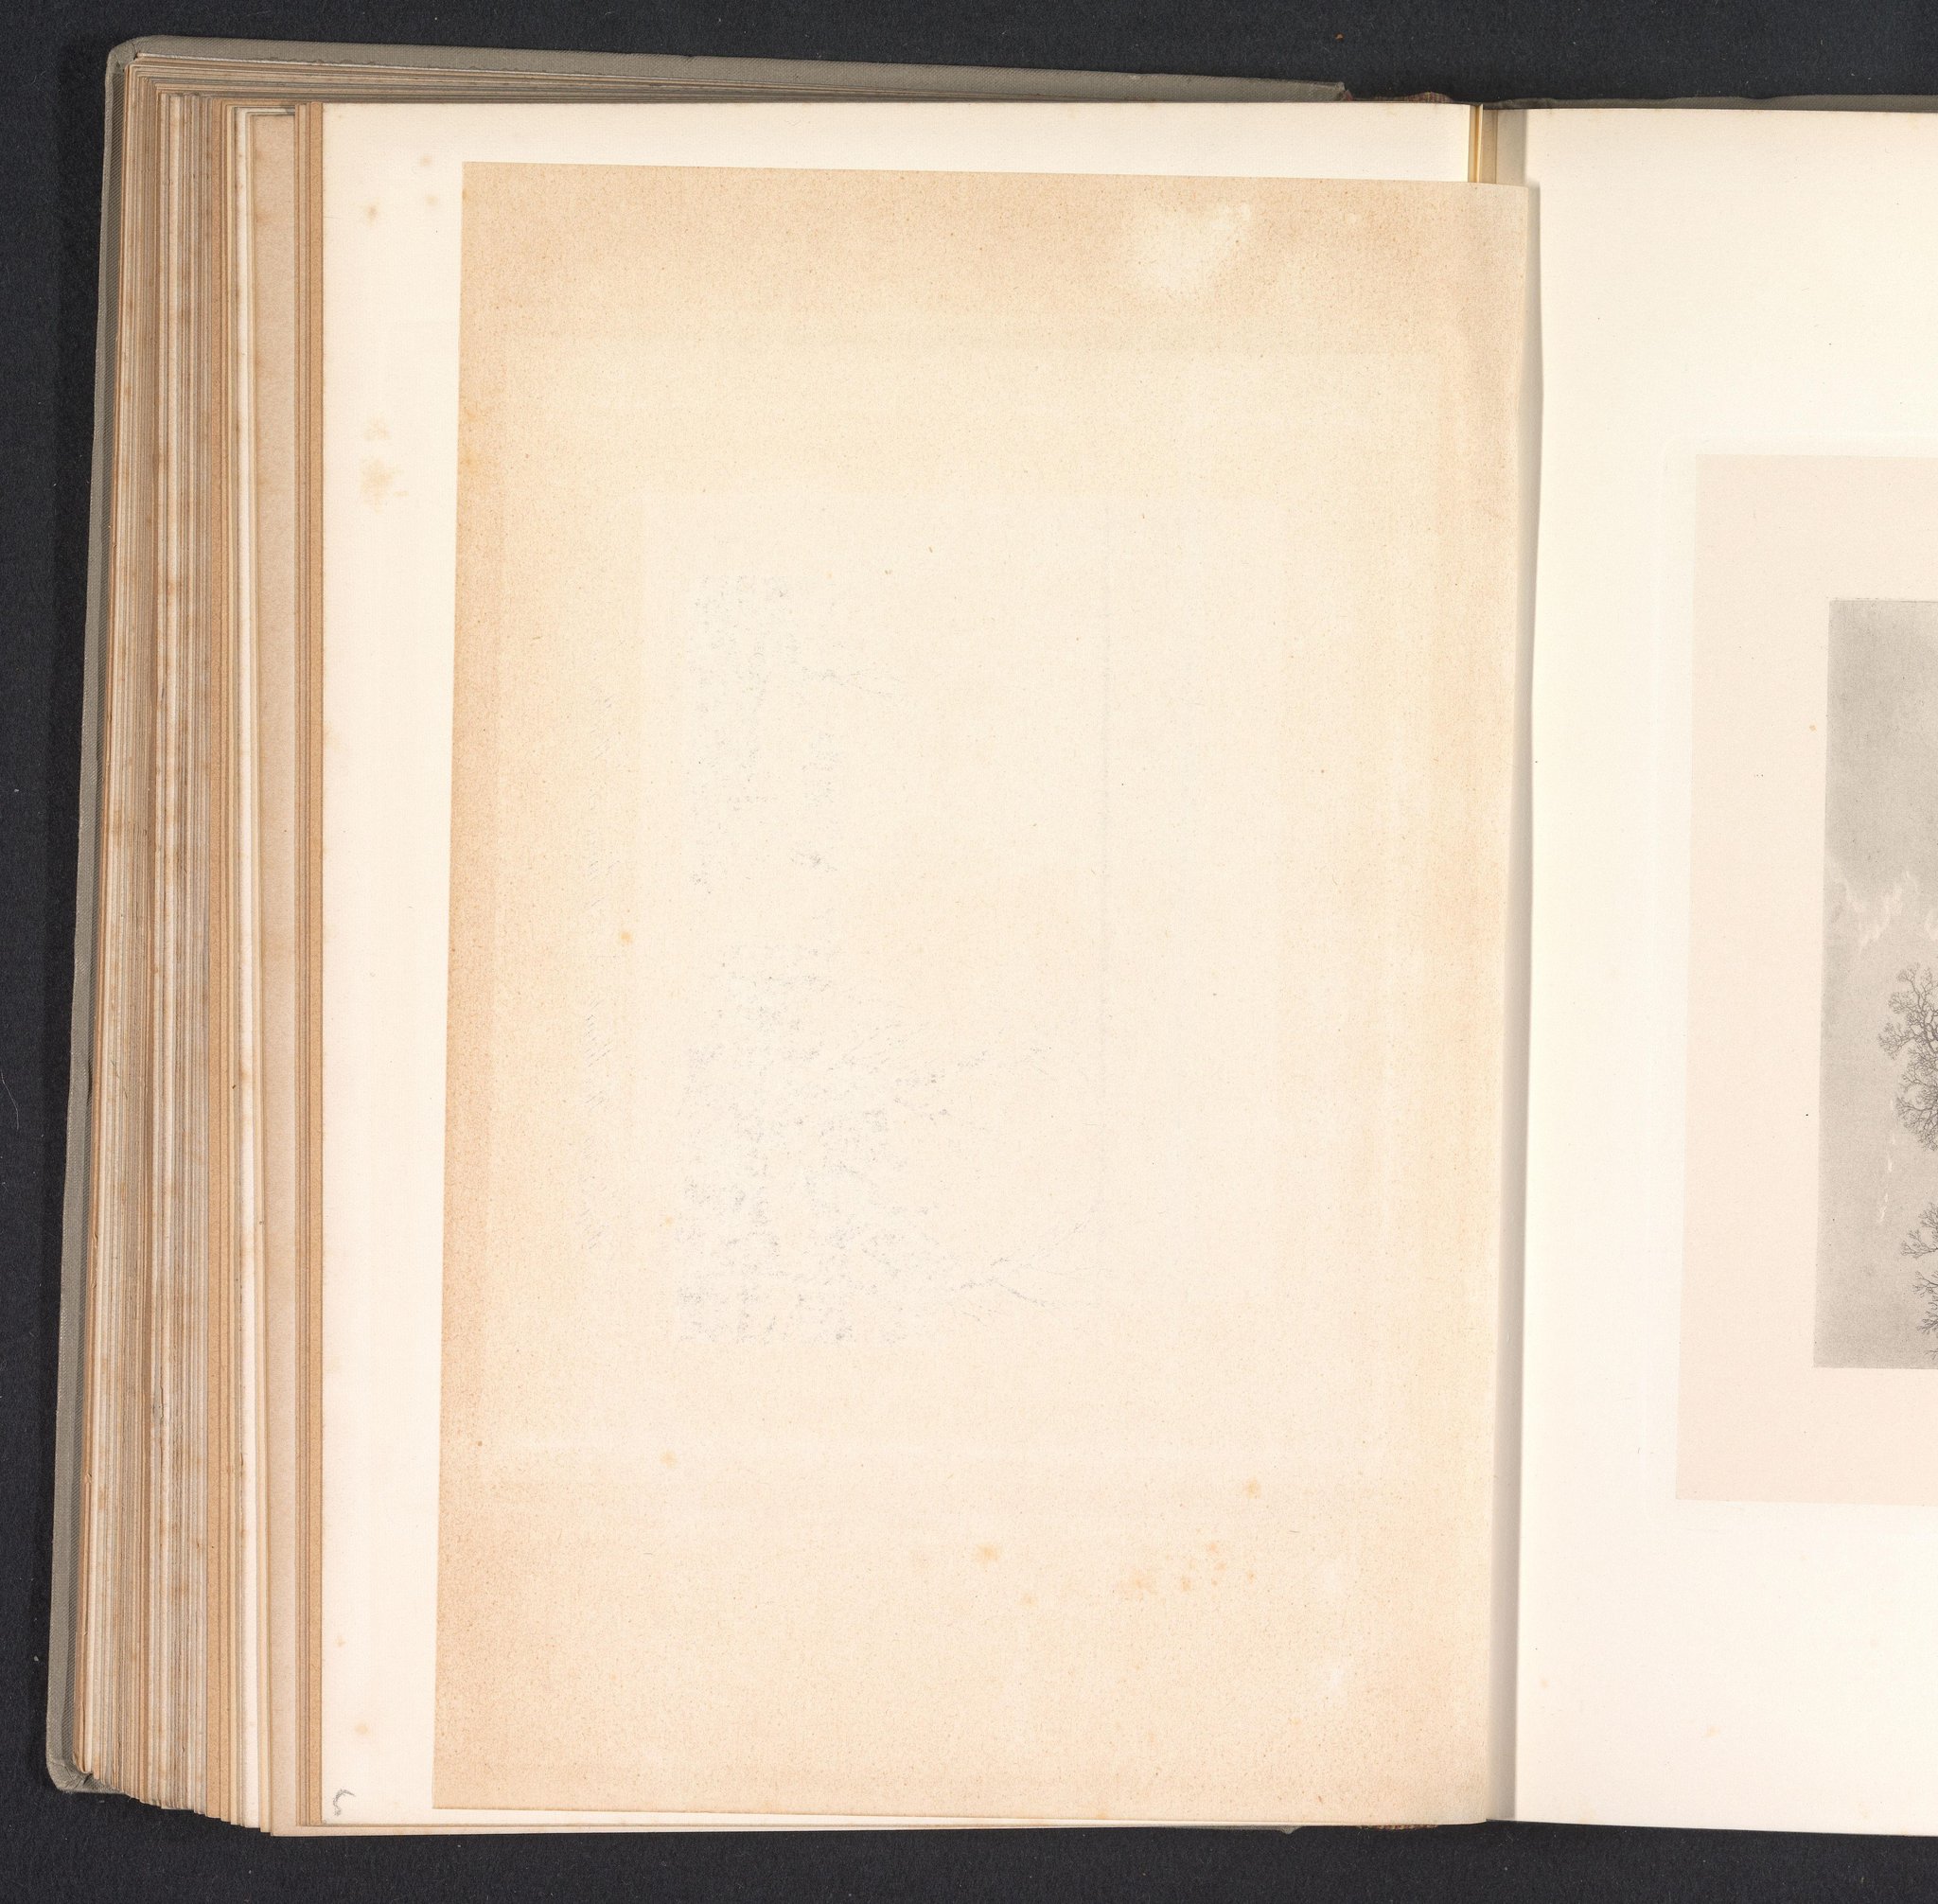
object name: photomechanical print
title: Winter in Holland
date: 1878-1883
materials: paper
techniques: photoaquatint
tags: winter landscape; landscape symbolizing winter (the four seasons of the year), skates (winter sports)